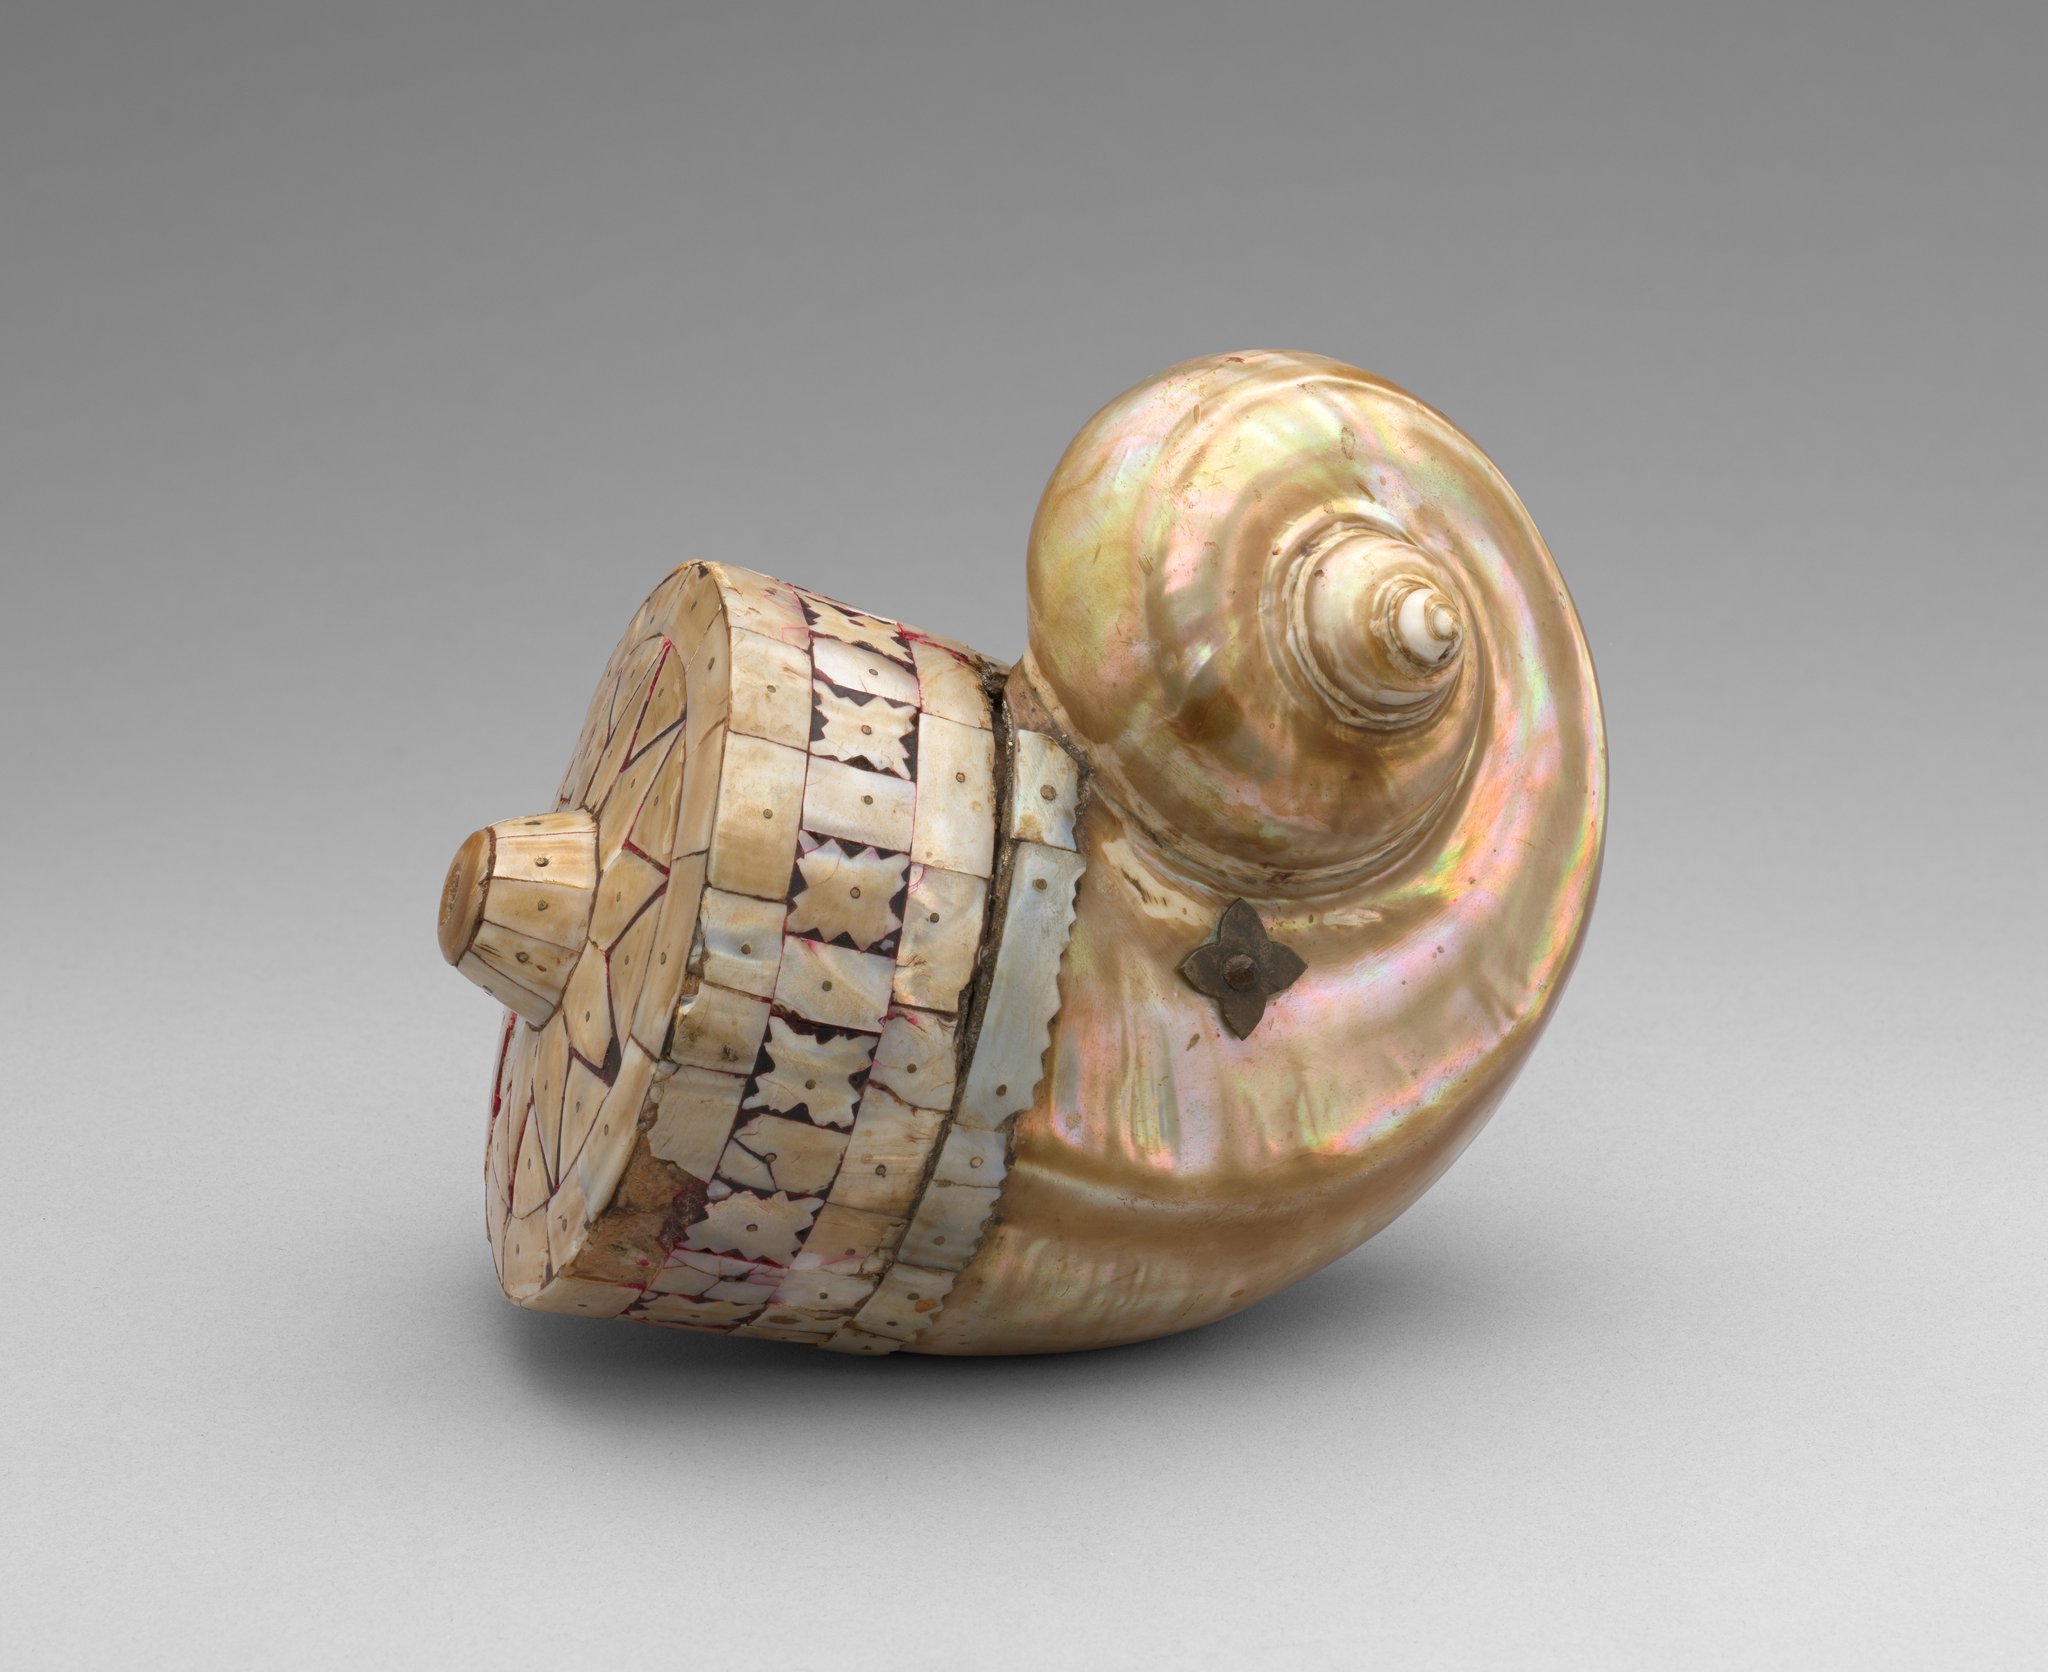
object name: covered container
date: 1701-1900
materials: brass, leather, shell